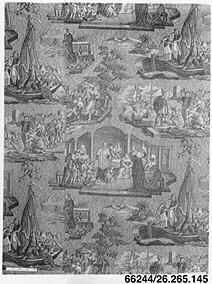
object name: furnishing textile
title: Scenes from the life of St. Vincent de Paul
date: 1818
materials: cotton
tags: human figures,trees,boats